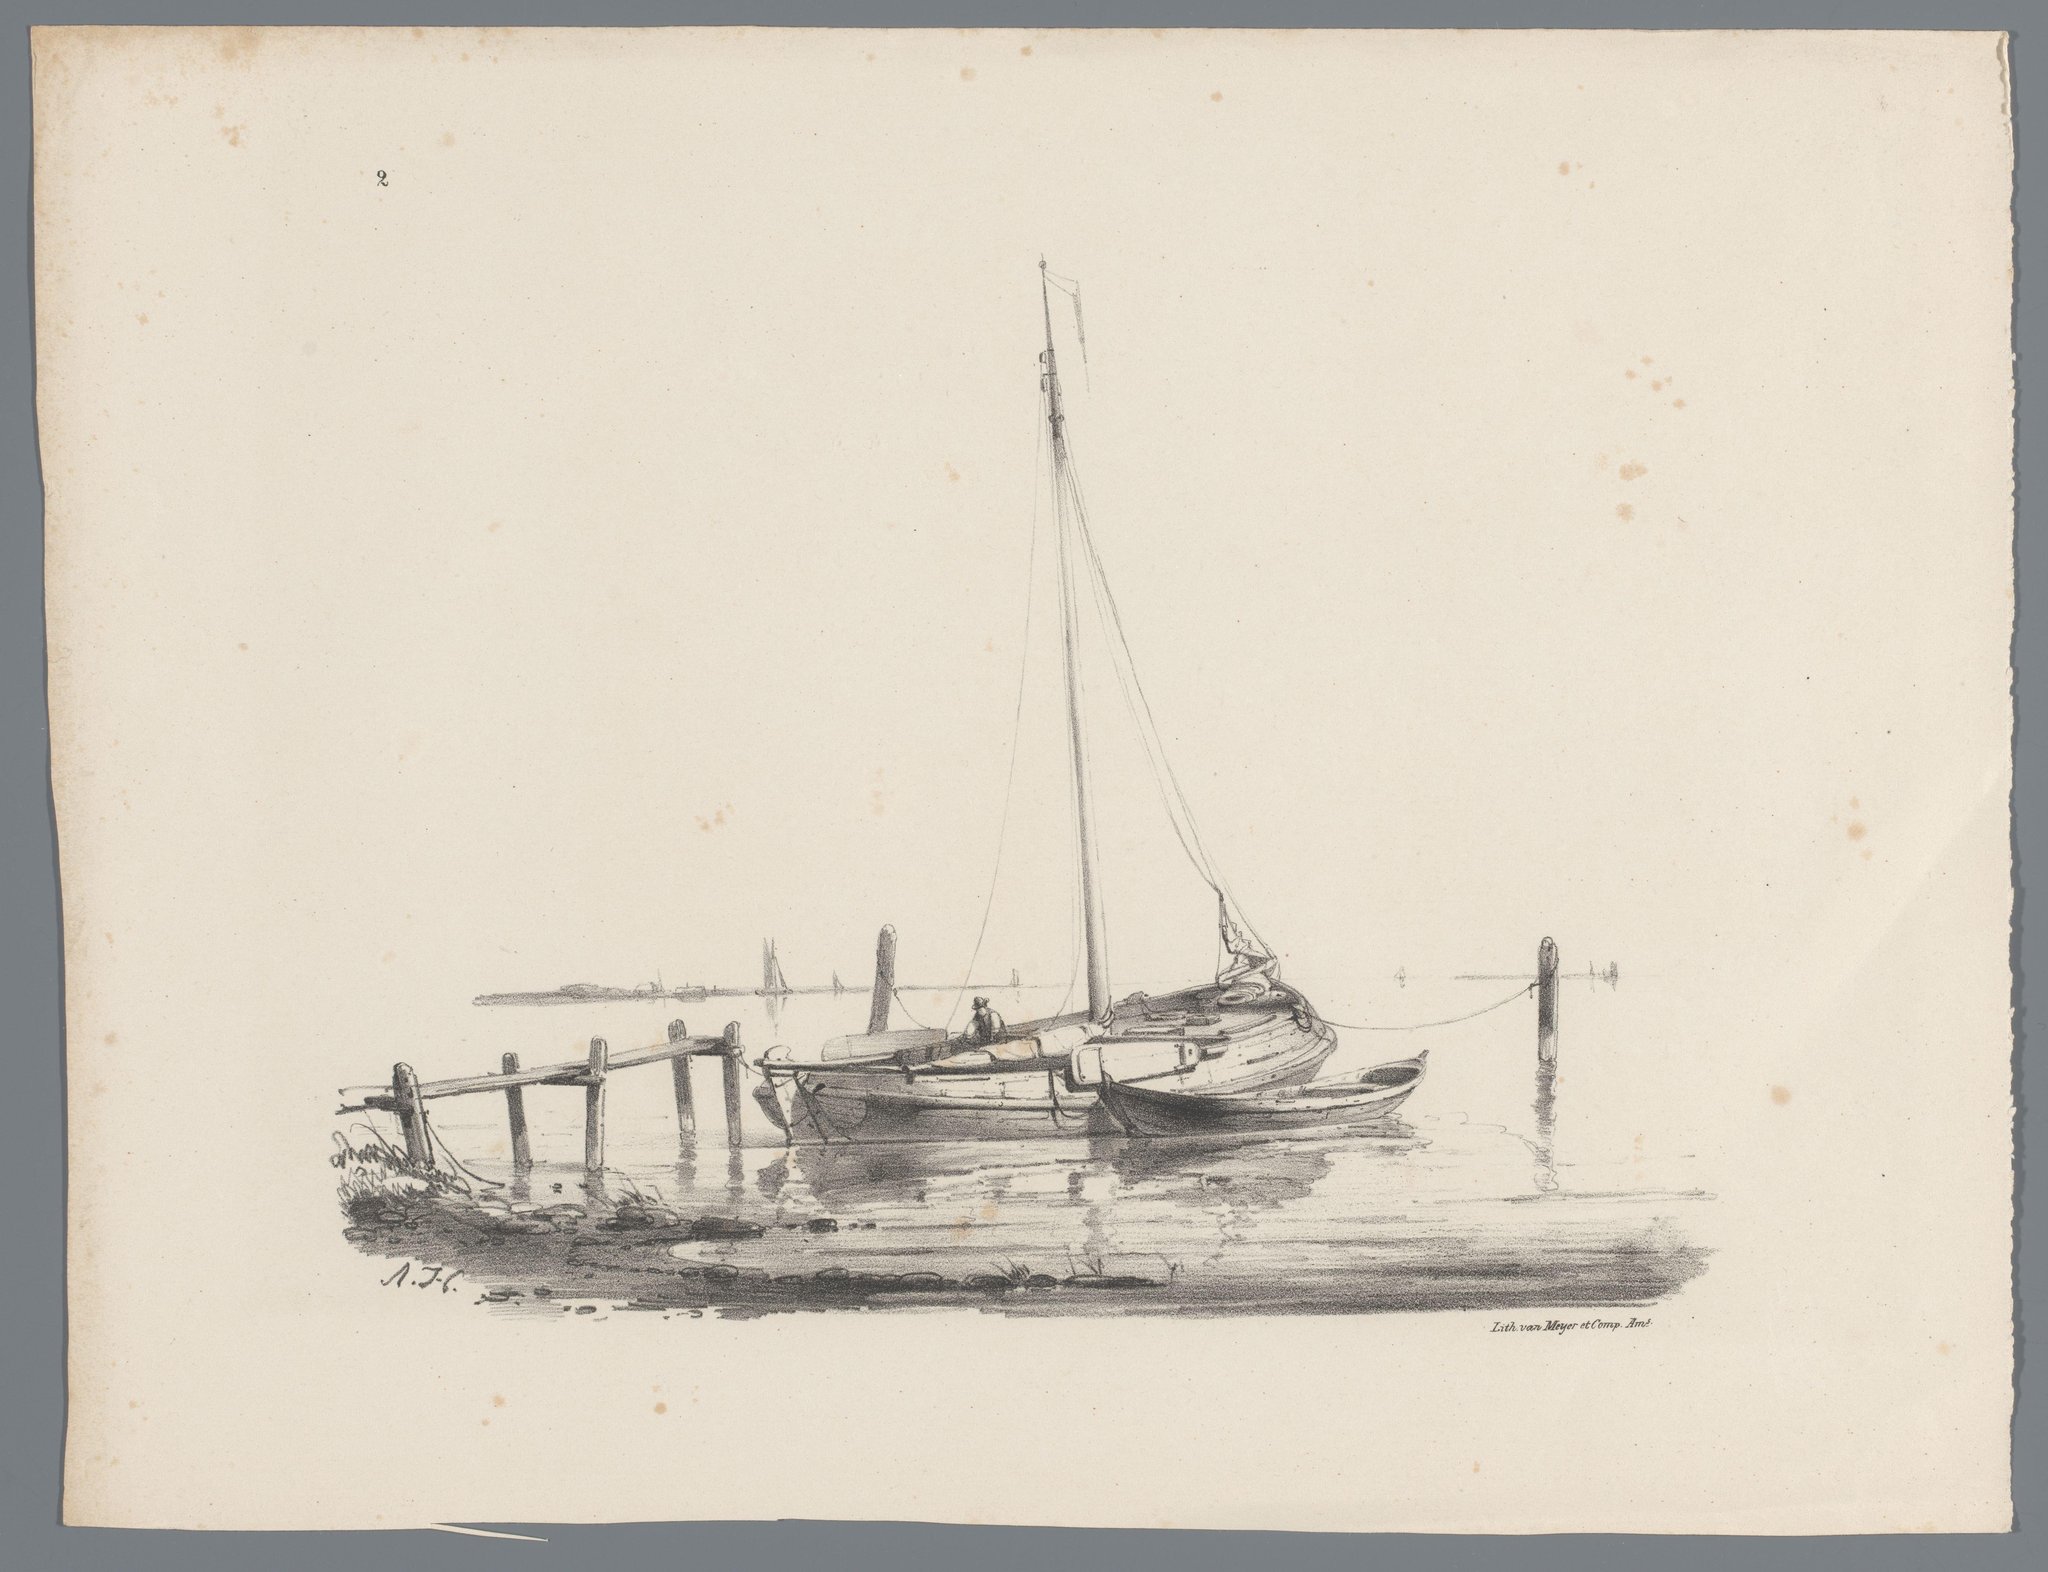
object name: print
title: Scheepstudien door A. Hulk tweede aflevering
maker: abraham hulk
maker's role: draughtsman, painter, print maker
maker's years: 1813-1897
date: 1843-1856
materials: paper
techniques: lithograph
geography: amsterdam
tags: sailing-ship, sailing-boat, rowing-boat, canoe, etc., pier, quay, wharf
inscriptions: collector's mark: Lugt 2228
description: Op de boot zit een man. Aan de zeilboot zit een roeiboot bevestigd. Genummerd linksboven: 2. Deze prent maakt deel uit van een omslag met vier losse prenten.